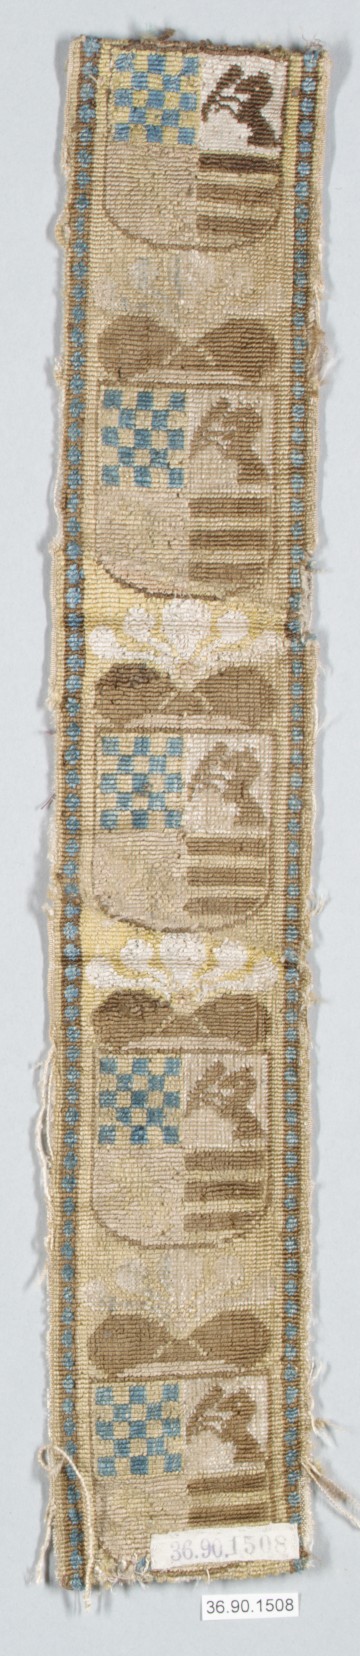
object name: galloon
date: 1701-1900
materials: silk